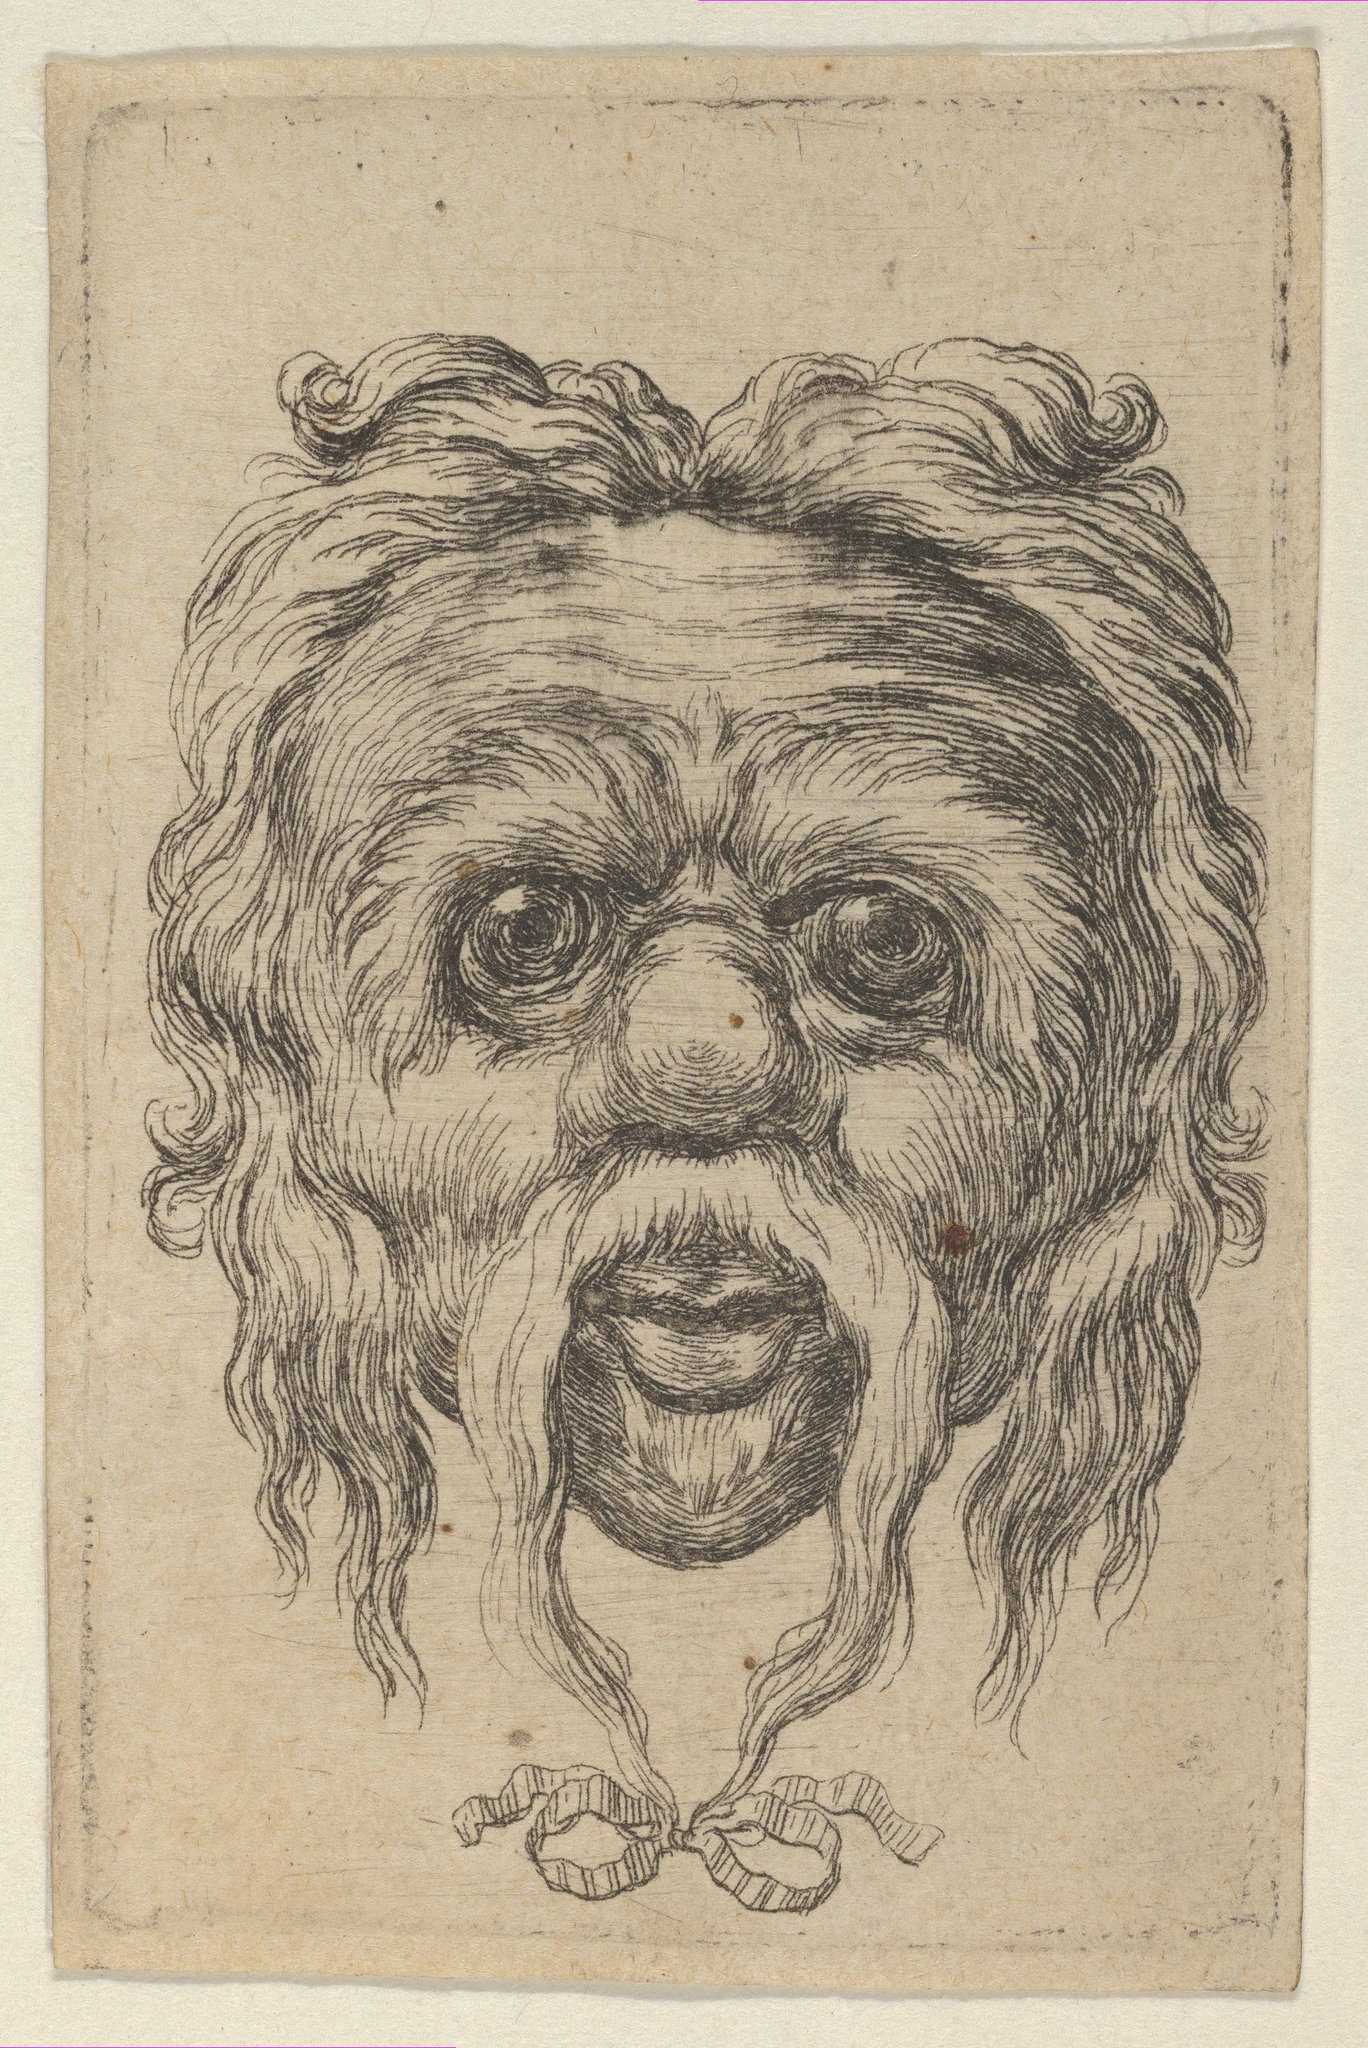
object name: print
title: Mask with a Long Mustache Tied with a Ribbon Beneath the Chin, from "Divers Masques"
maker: françois chauveau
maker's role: artist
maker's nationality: french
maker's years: 1613-1676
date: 1635-1645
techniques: etching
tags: masks